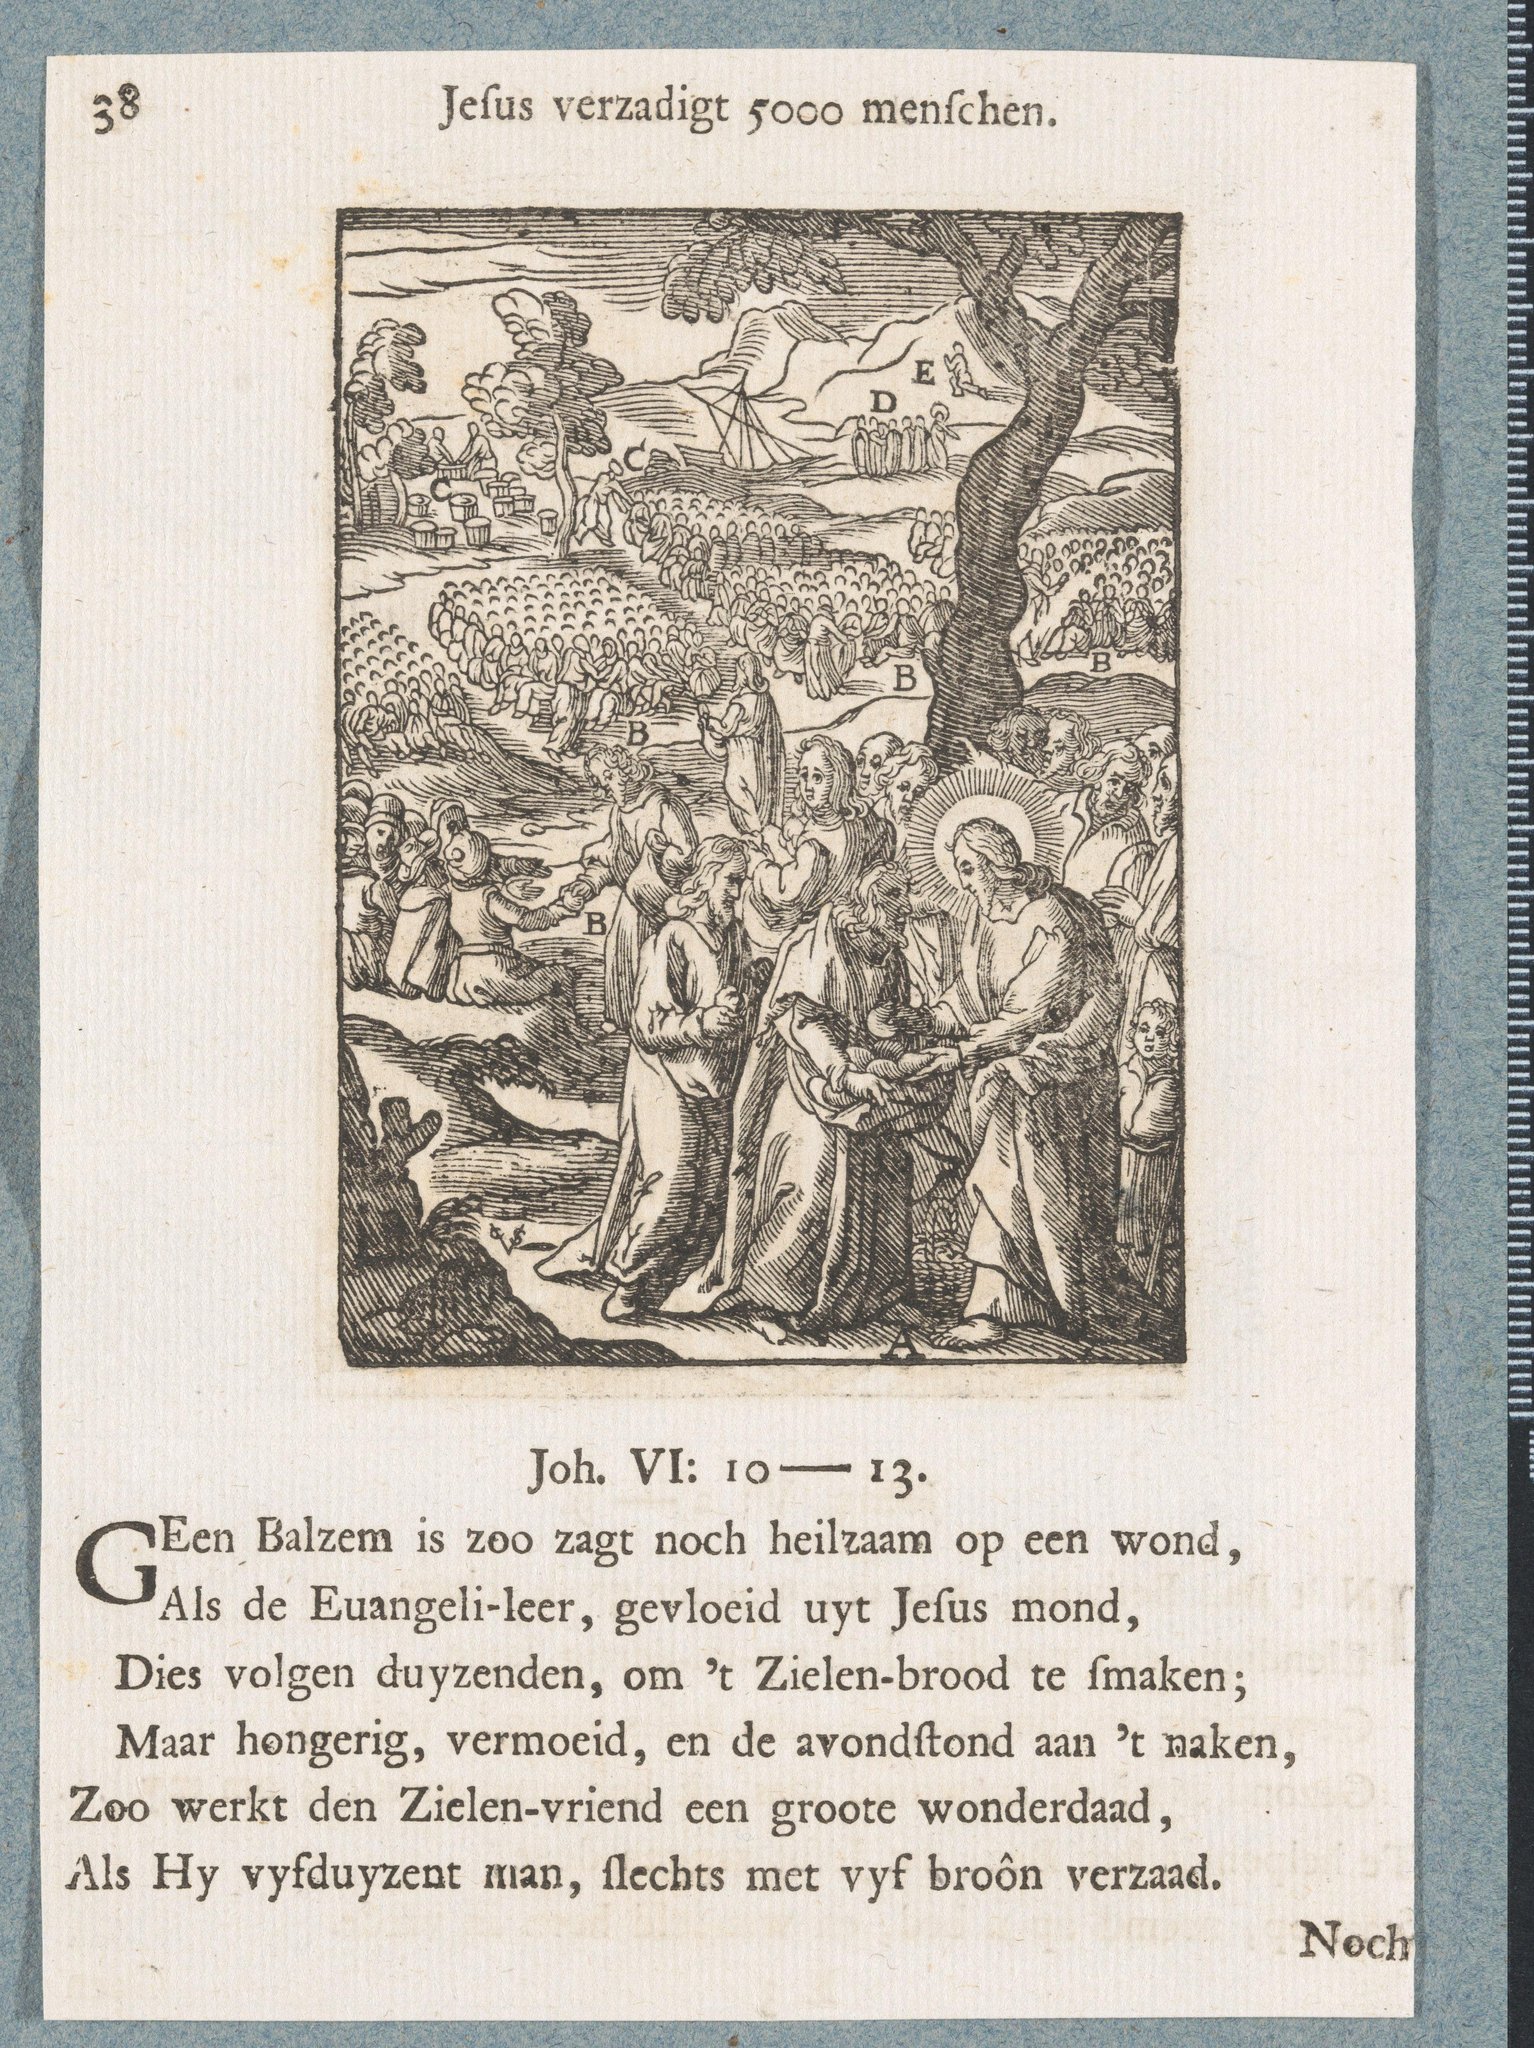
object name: album leaf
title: Tweede wonderbaarlijke spijziging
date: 1629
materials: paper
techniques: letterpress printing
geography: amsterdam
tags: multiplication of loaves and fishes for a multitude of four or five thousand people (matthew 14:13-21, 15:32-39; mark 6:32-44, 8:1-10; luke 9:10-17; john 6:1-14)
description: De prent is afkomstig uit: Bybels Lusthof. Amsterdam, J. Klooster, 1740. De prent werd gemaakt voor de uitgaven van P.J. Paets uit Amsterdam, verschenen in de jaren 1629-1648. Ze komt voor het eerst voor in: Der Zielen Lust-hof. Leuven, I.Jacbosz voor P.J. Paets [= Amsterdam, P.J. Paets], 1629. De voorstelling is gekopieerd naar een prent van Antonie II Wierix voor: Nadal, Jerónimo. Evangelicae Historiae Imagines. Antwerpen, M. Nutius, 1593.